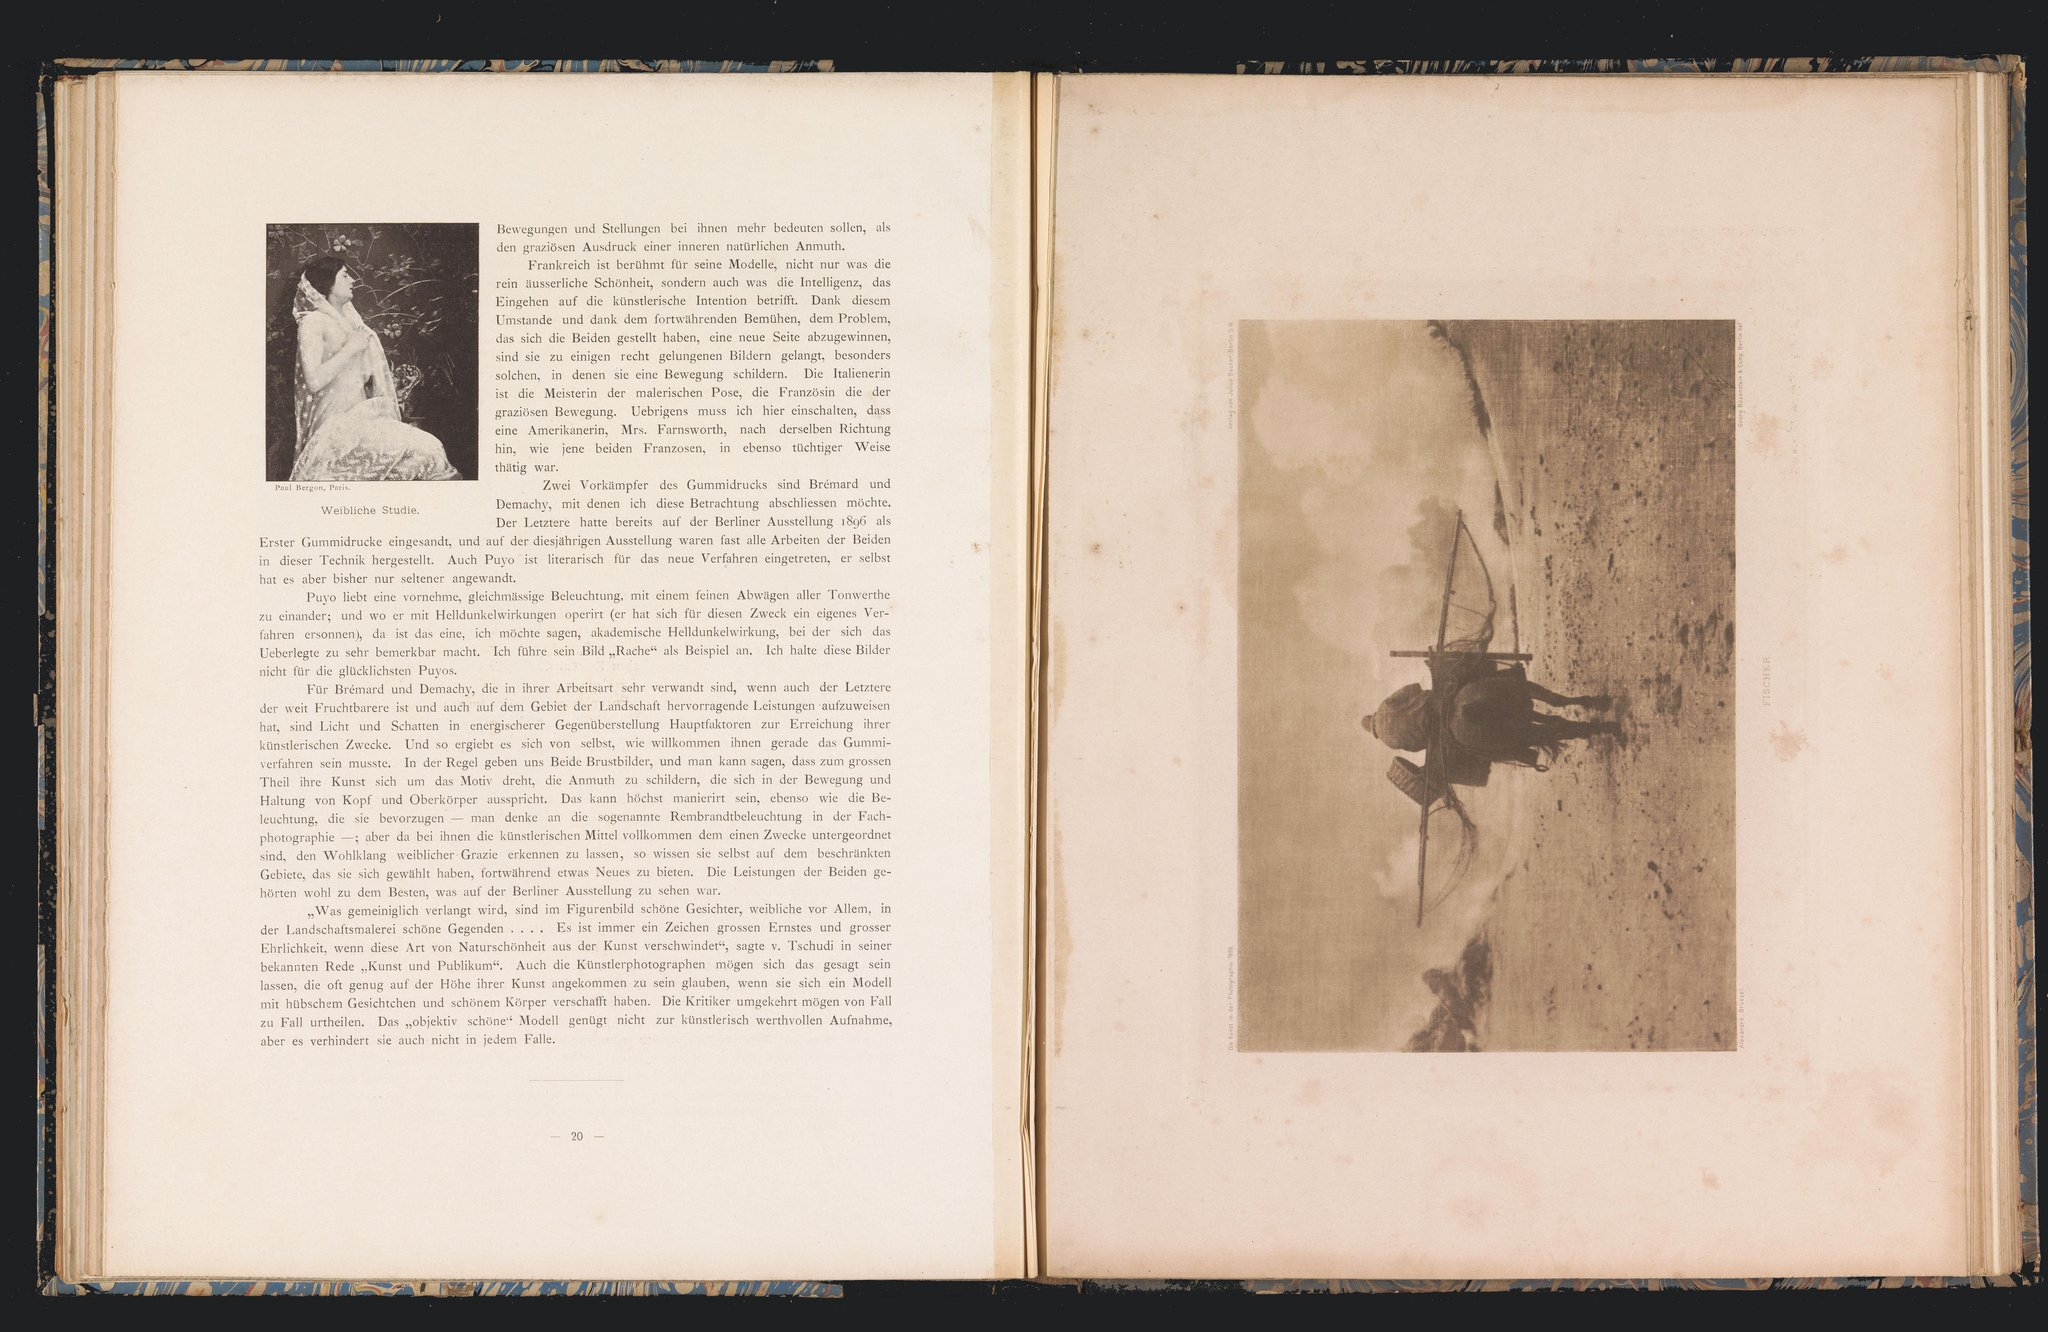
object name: photomechanical print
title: Weibliche Studie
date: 1889-1899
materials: paper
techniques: autotype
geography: germany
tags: woman (showing herself) undressed, quasi-nude, veil, anonymous historical person portrayed - bb - woman